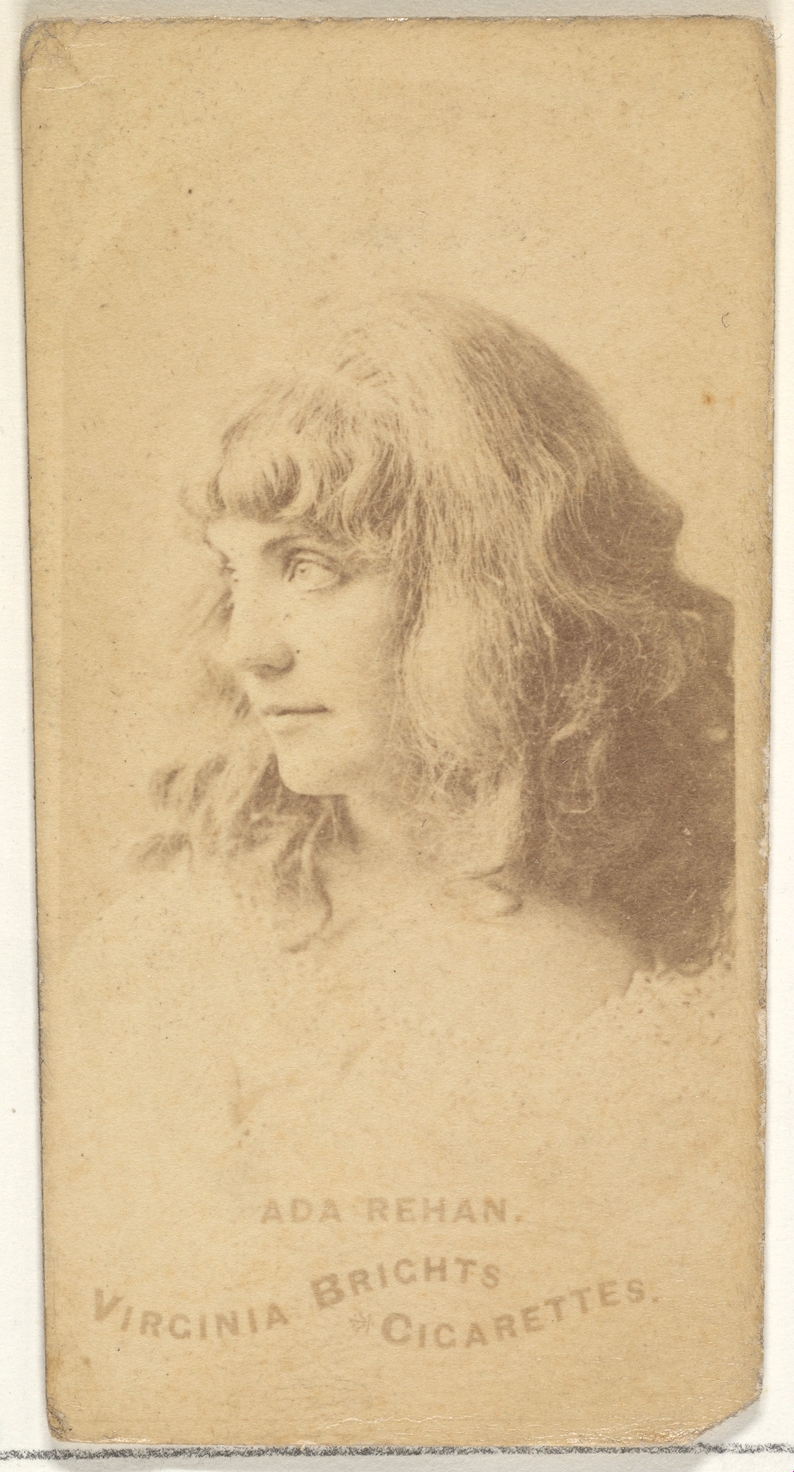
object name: photograph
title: Ada Rehan, from the Actors and Actresses series (N45, Type 1) for Virginia Brights Cigarettes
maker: allen & ginter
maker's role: publisher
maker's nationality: american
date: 1888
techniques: albumen silver print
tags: portraits,women,actresses